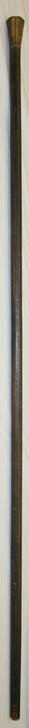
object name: cane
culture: italian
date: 1801-1833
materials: wood